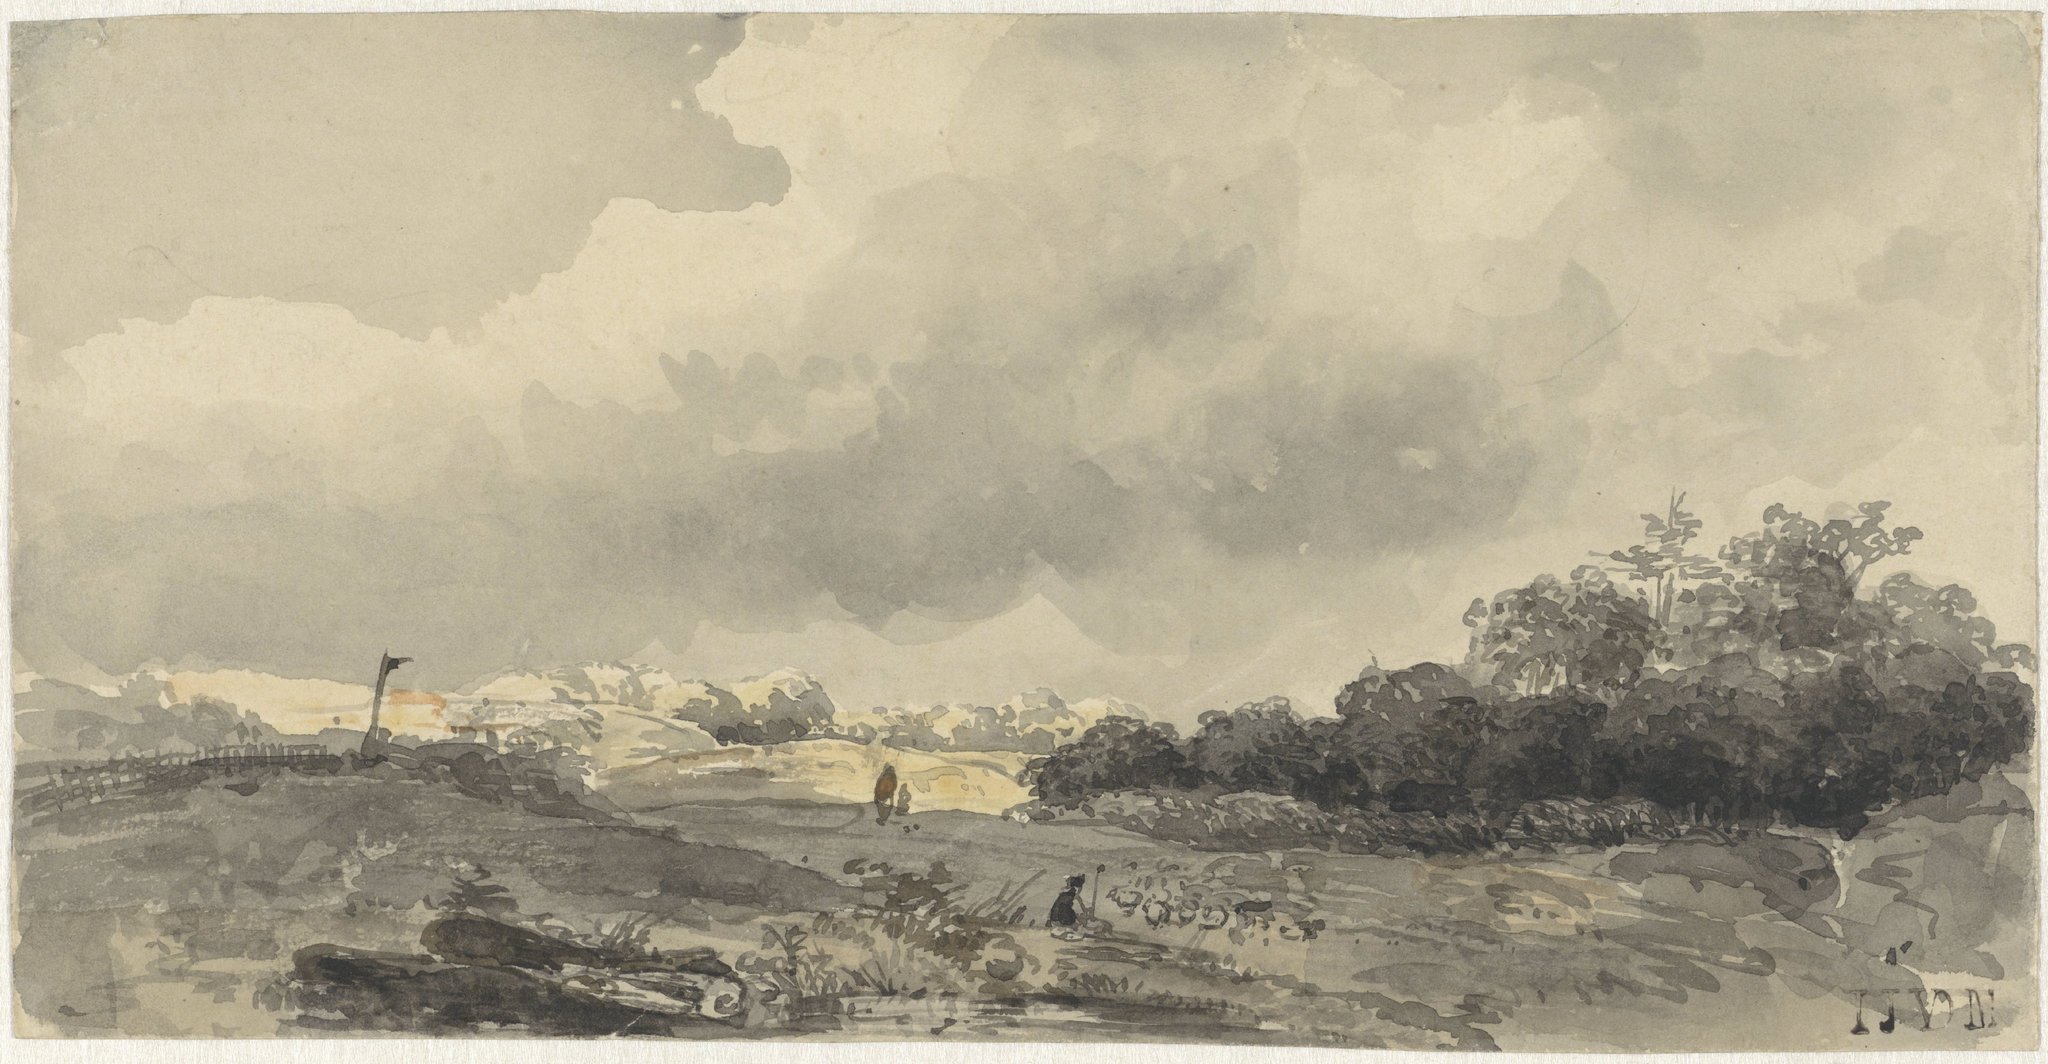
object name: drawing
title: Landschap met schaapherder onder zware wolkenlucht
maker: jacob jan van der maaten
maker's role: draughtsman, print maker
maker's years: 1820-1879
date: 1830-1879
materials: paper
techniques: brush